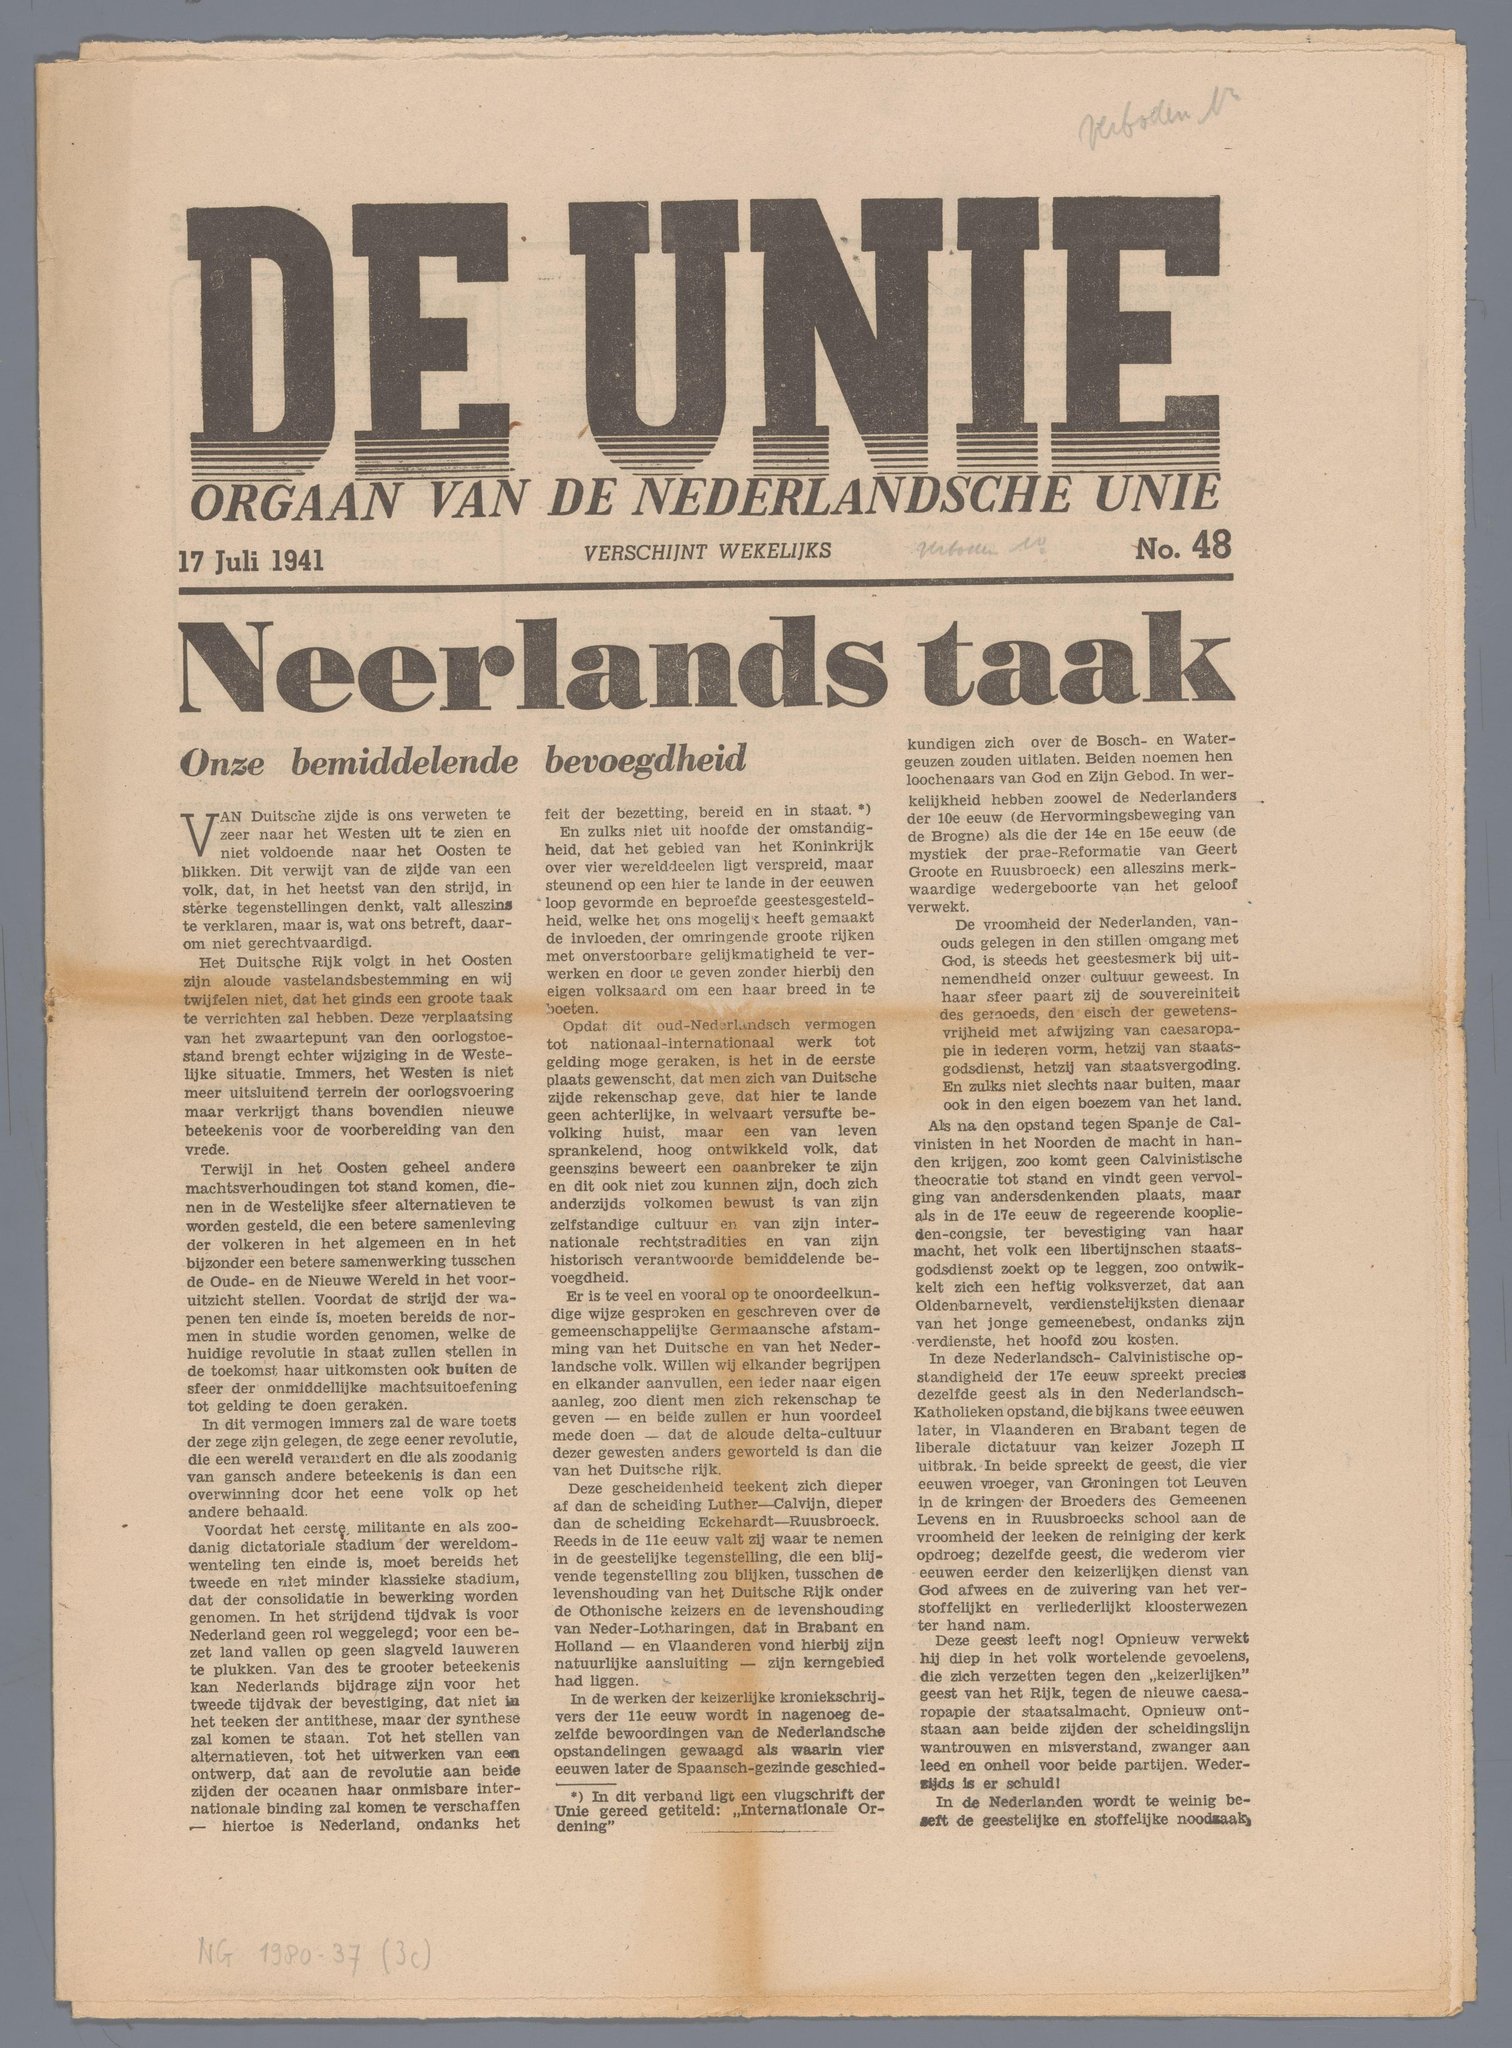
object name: newspaper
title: De Unie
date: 1941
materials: paper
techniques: printing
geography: the hague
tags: netherlands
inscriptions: date